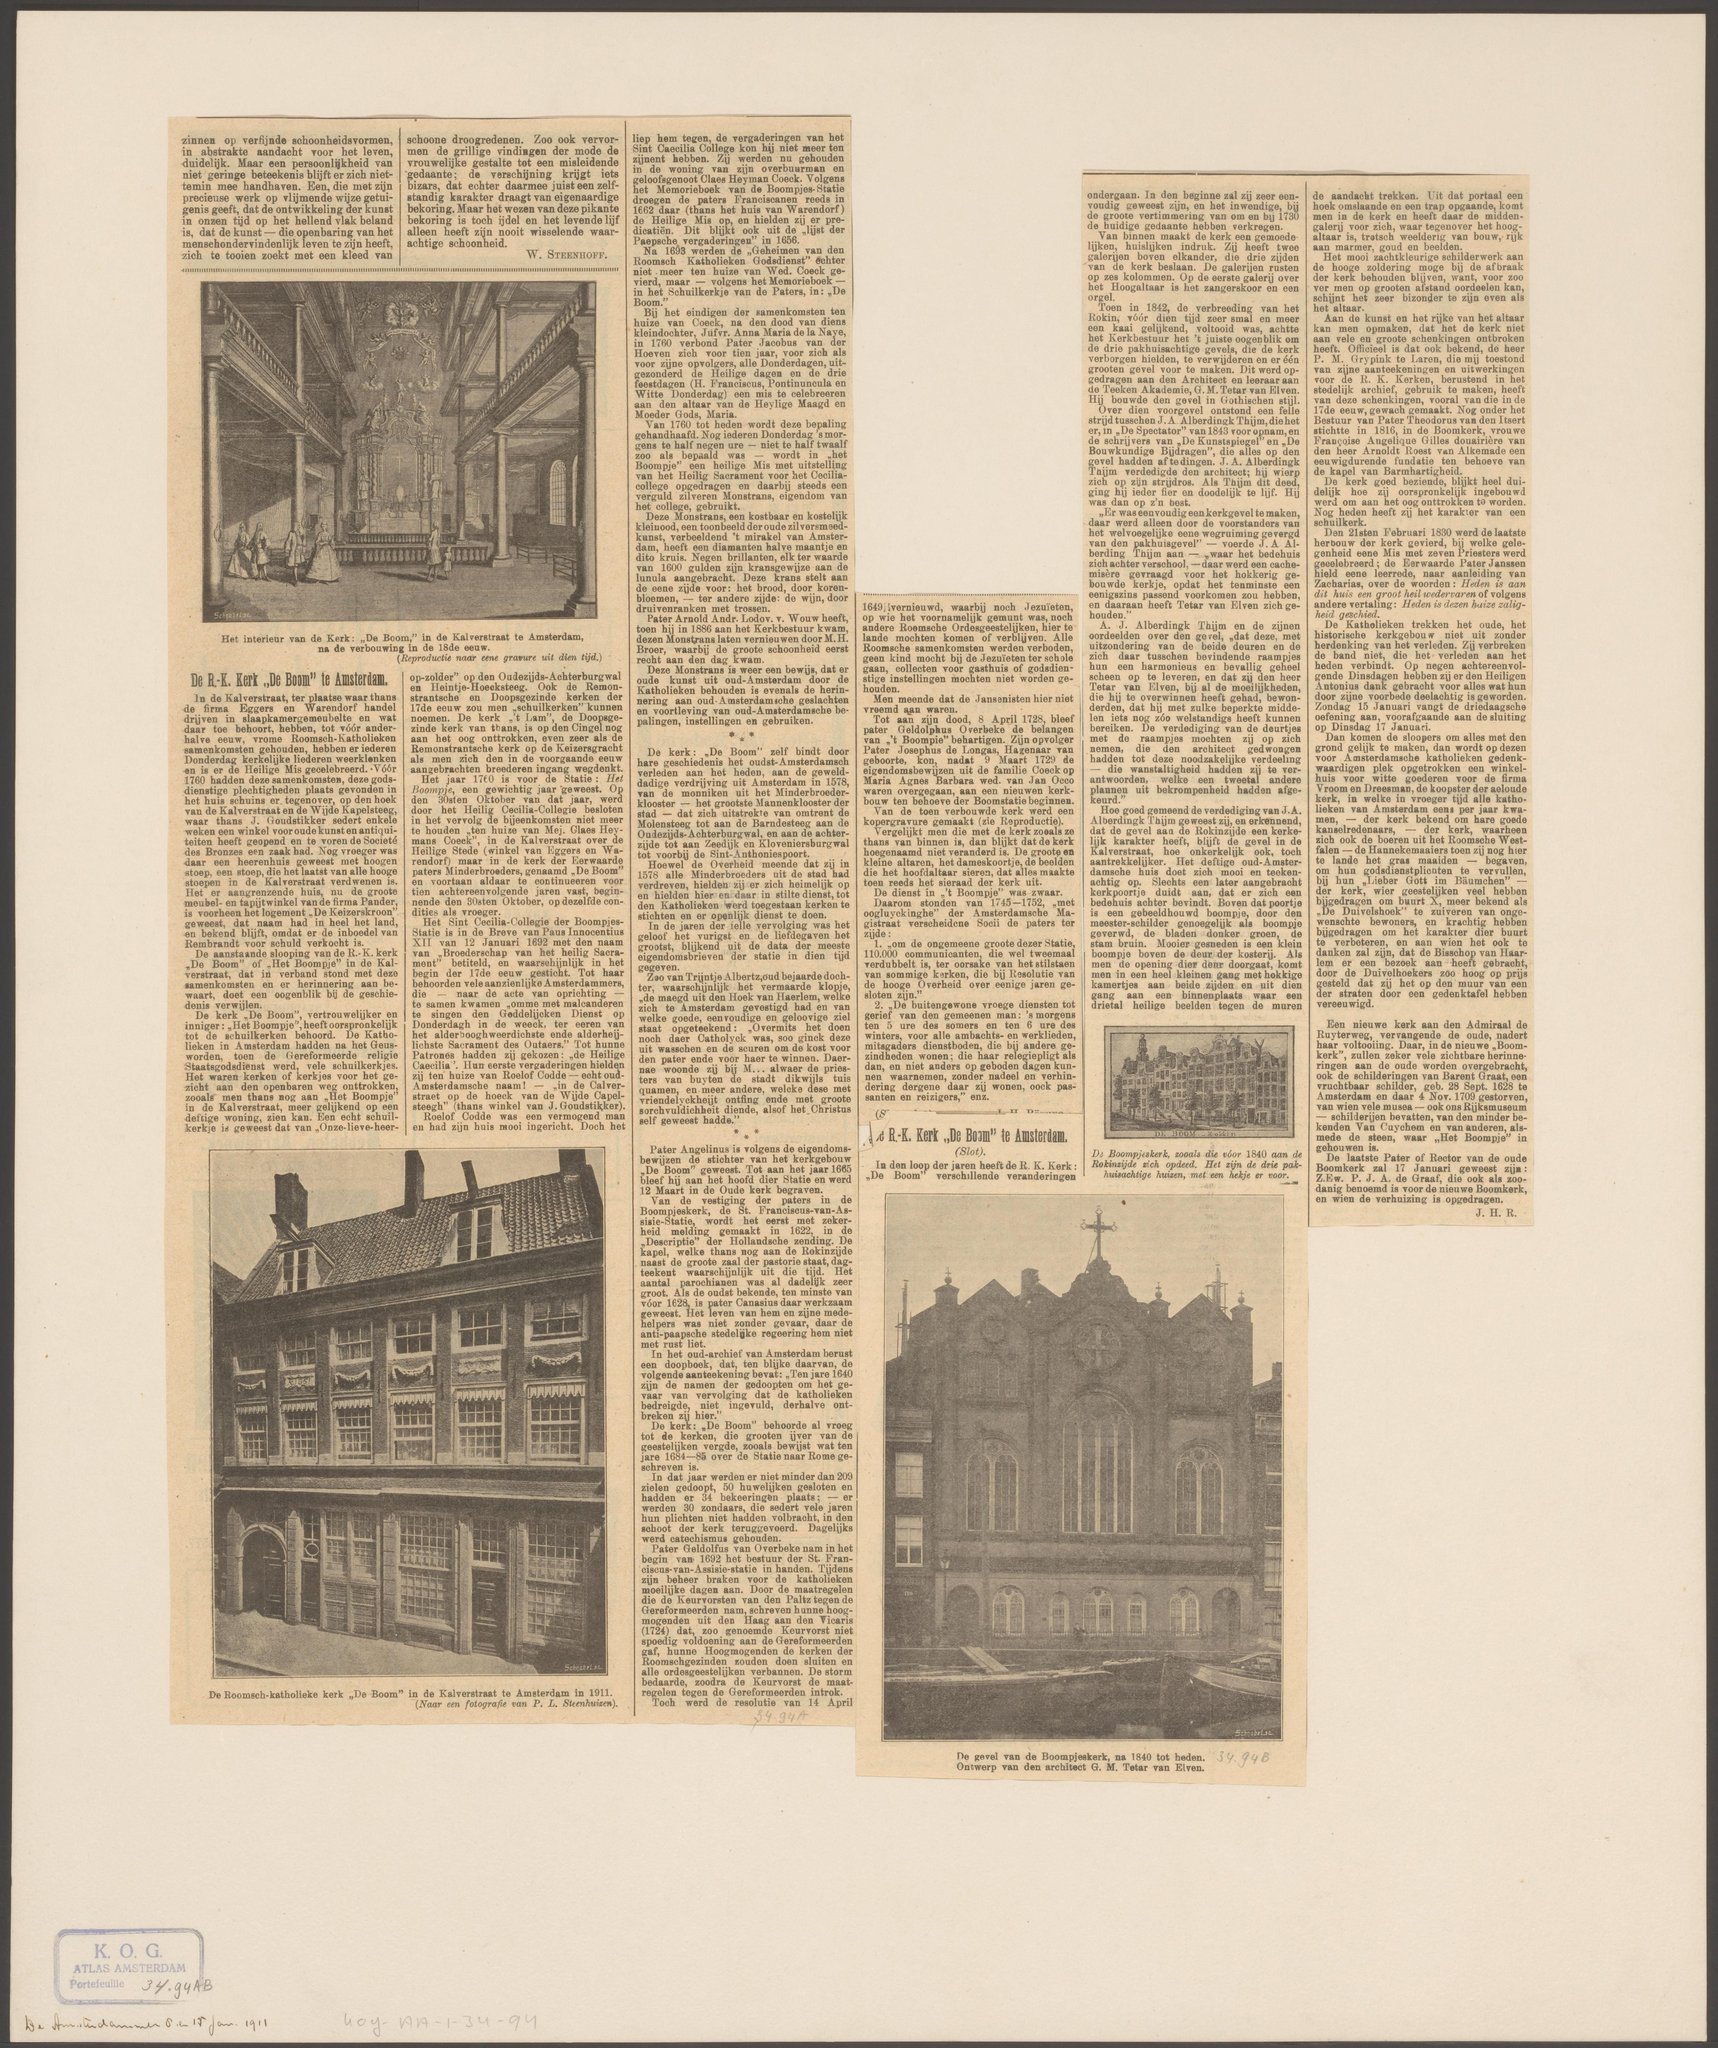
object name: photomechanical print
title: De R.-K. Kerk "De Boom" te Amsterdam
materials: paper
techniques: letterpress printing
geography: amsterdam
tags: church (exterior), interior of church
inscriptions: collector's mark: Lugt 1641b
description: Object bestaat uit twee aan elkaar geplakte bladen. Het betreft een artikel dat over twee opeenvolgende publicaties van De Amsterdammer verscheen. Onderwerpsrubriek binnen de Atlas Amsterdam: Kerkwezen: R.K. Gemeenten: Begijnhof t/m Petrus en Paulus.